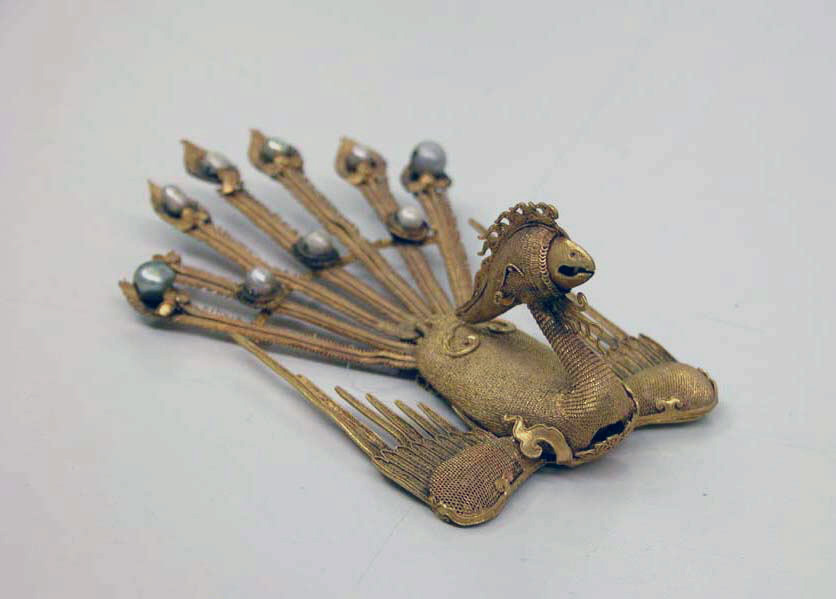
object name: ornament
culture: chinese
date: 960-1279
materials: gold, pearl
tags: birds